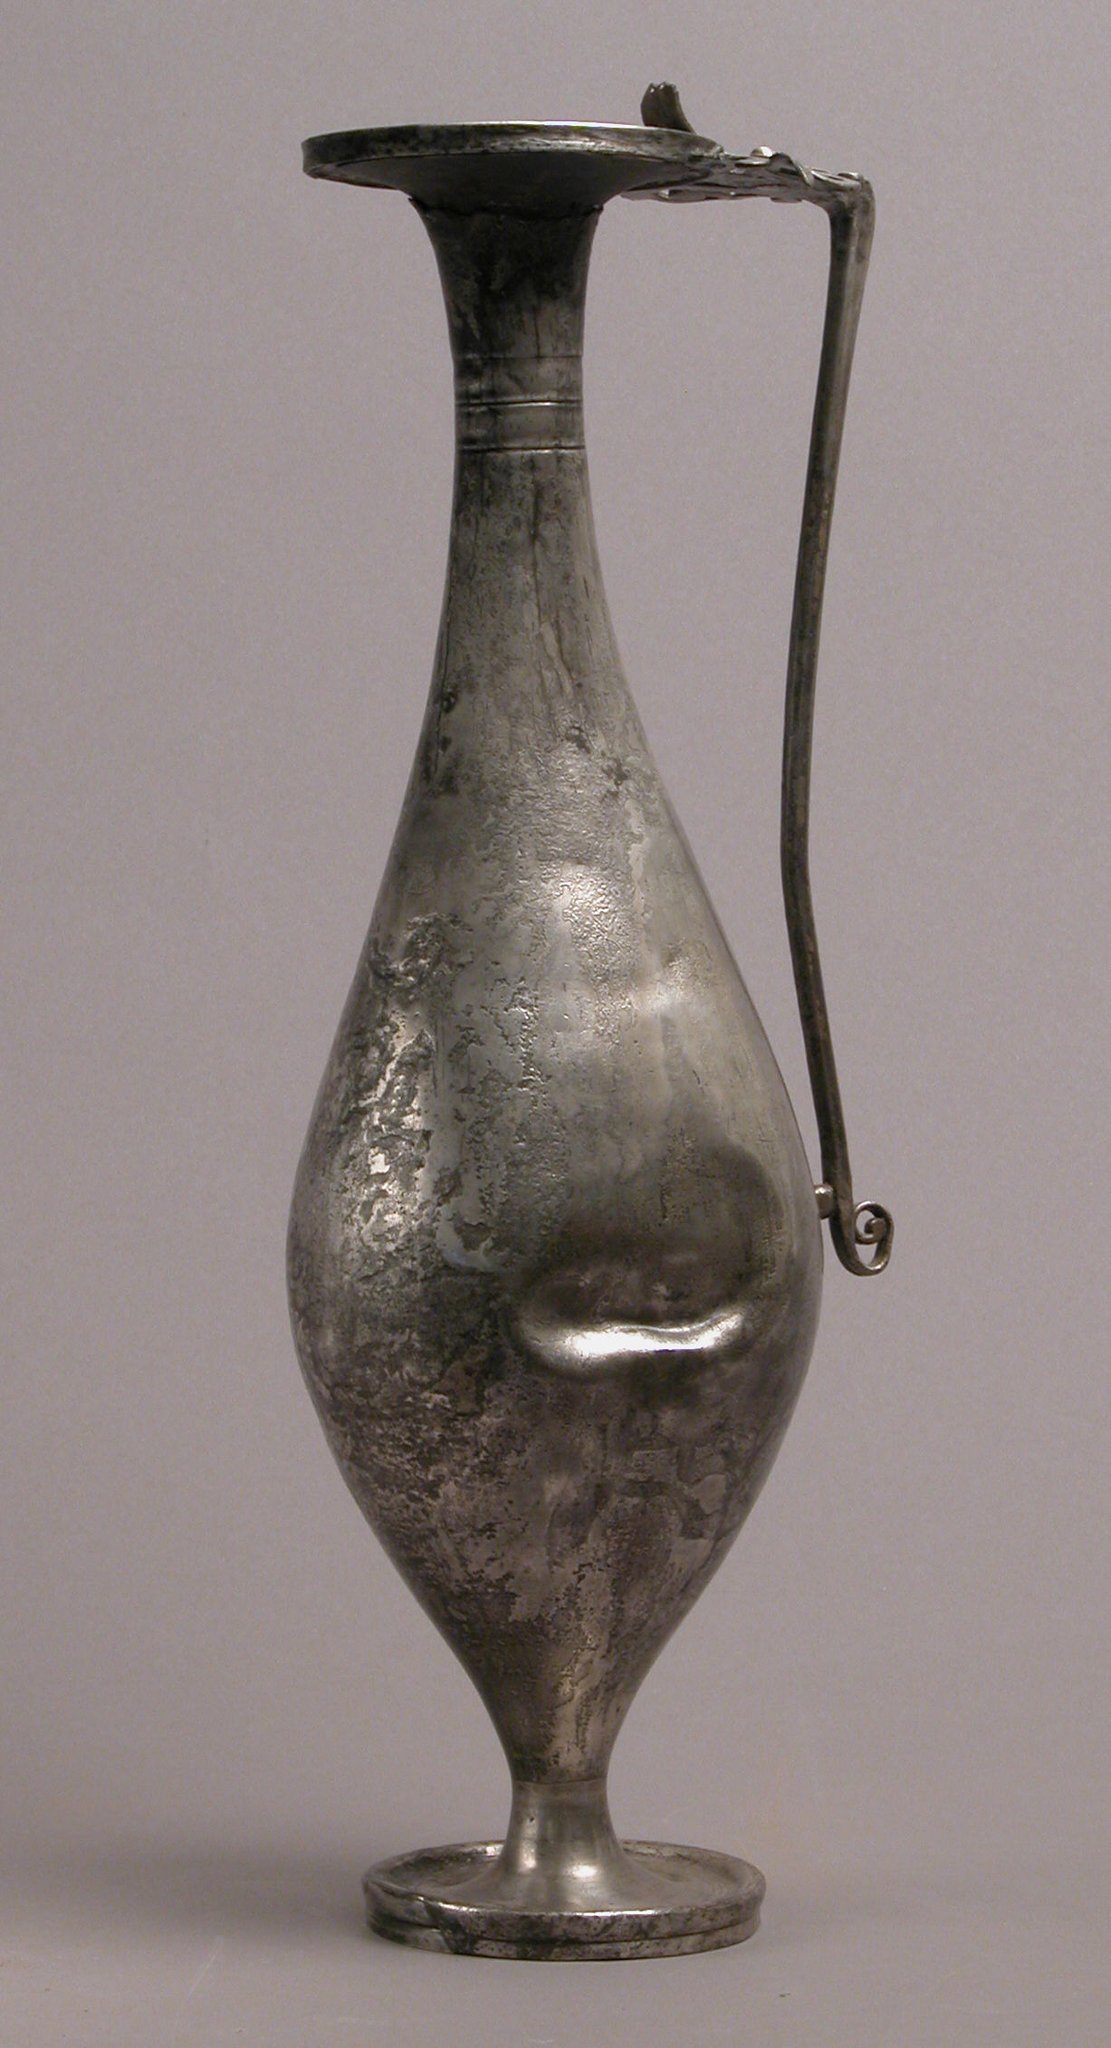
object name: ewer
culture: byzantine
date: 301-500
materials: silver